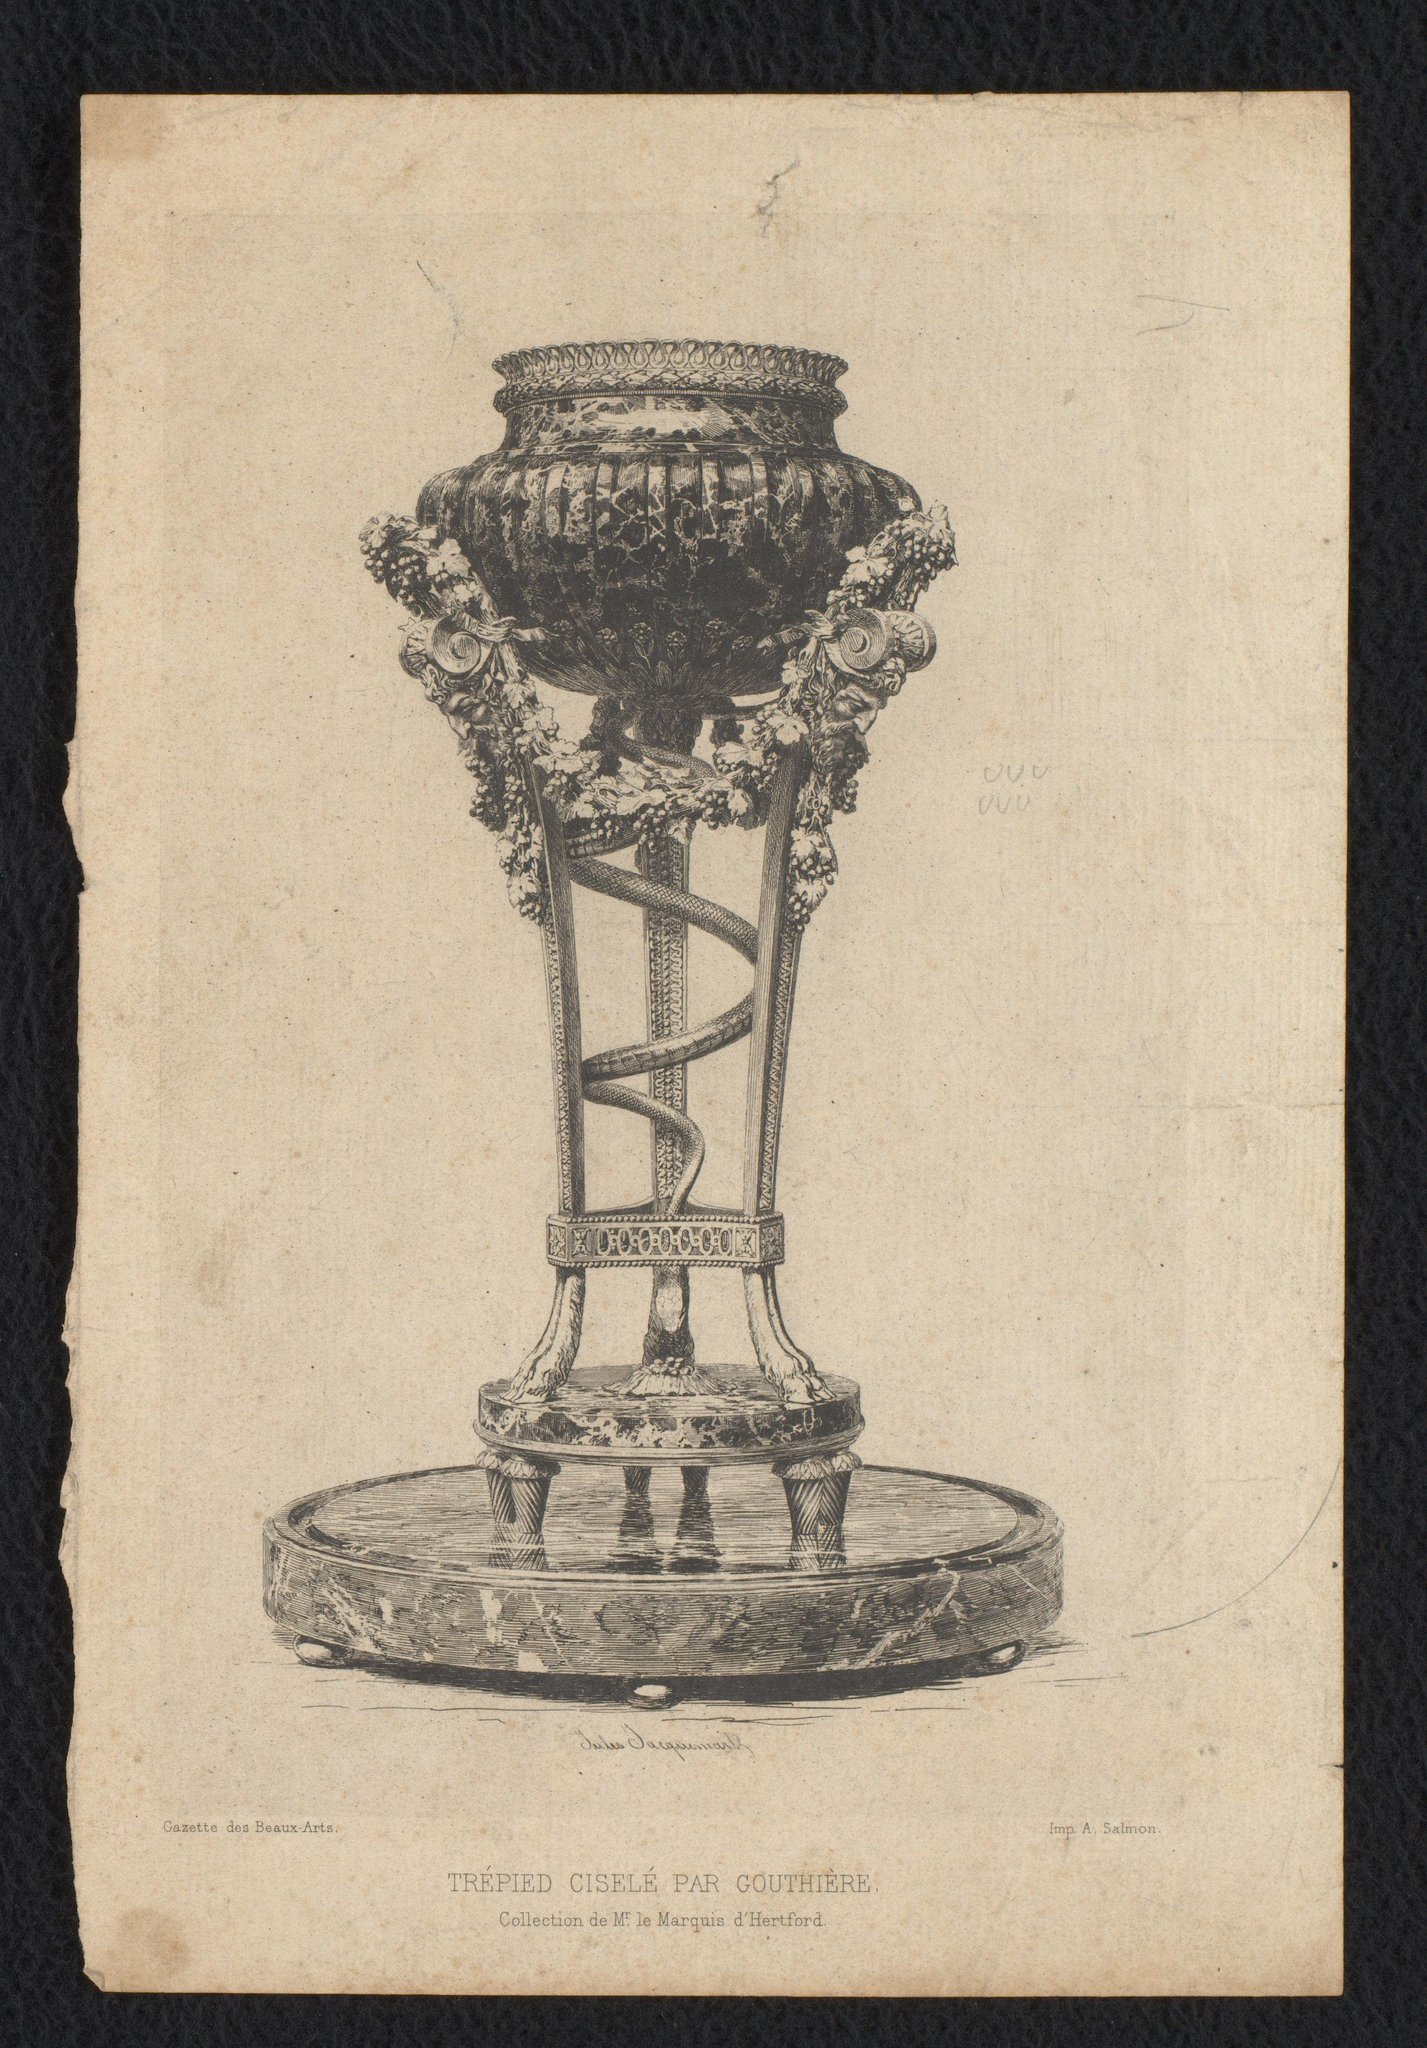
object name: photograph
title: Fontein rustend op een driepoot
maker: Anonymous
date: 1860-1900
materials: paper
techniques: mechanical process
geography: sevilla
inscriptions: title: ‘gazette de Beaux Arts , Imp. A. Salmon’, annotation: ‘Trepied cisele par Gouthiere, collection de Mr le Marquis d'Hertford.’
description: Onderdeel van een serie met betrekking tot het interieur van het paleis van Versailles met kroonluchters, deuren, portalen en meubelstukken.